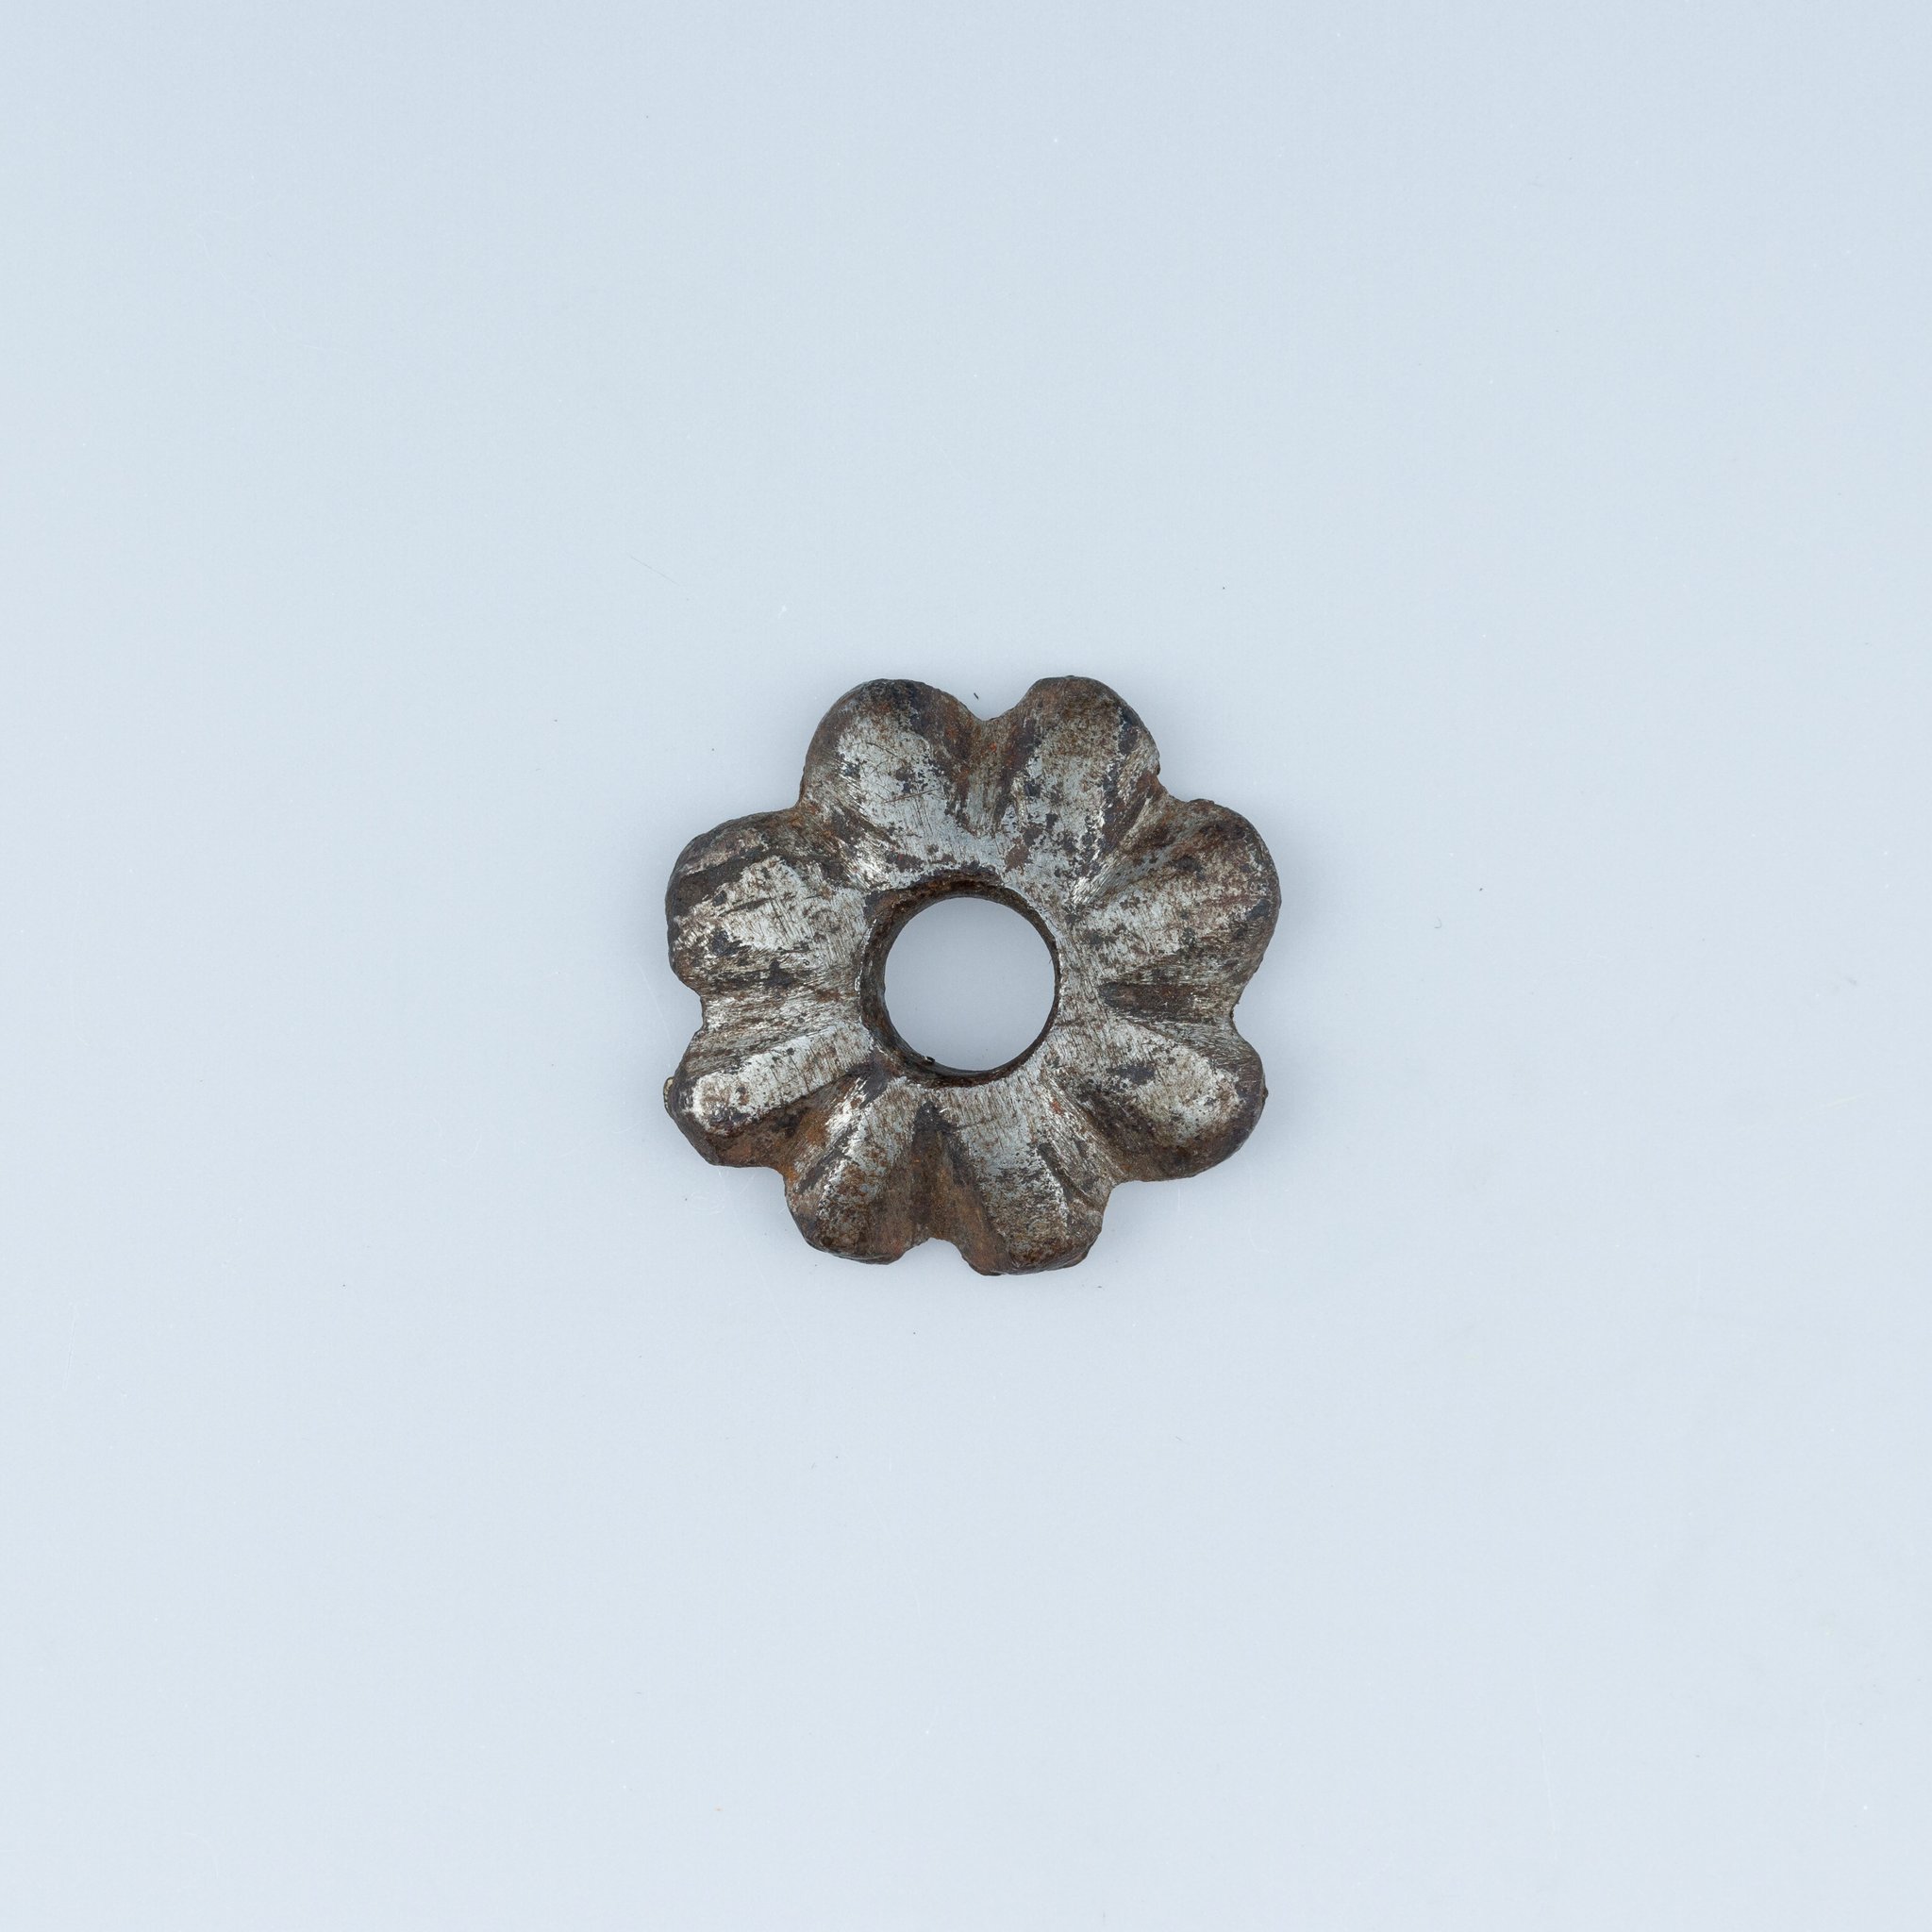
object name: rosette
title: Rosette for Visor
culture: german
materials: steel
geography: germany